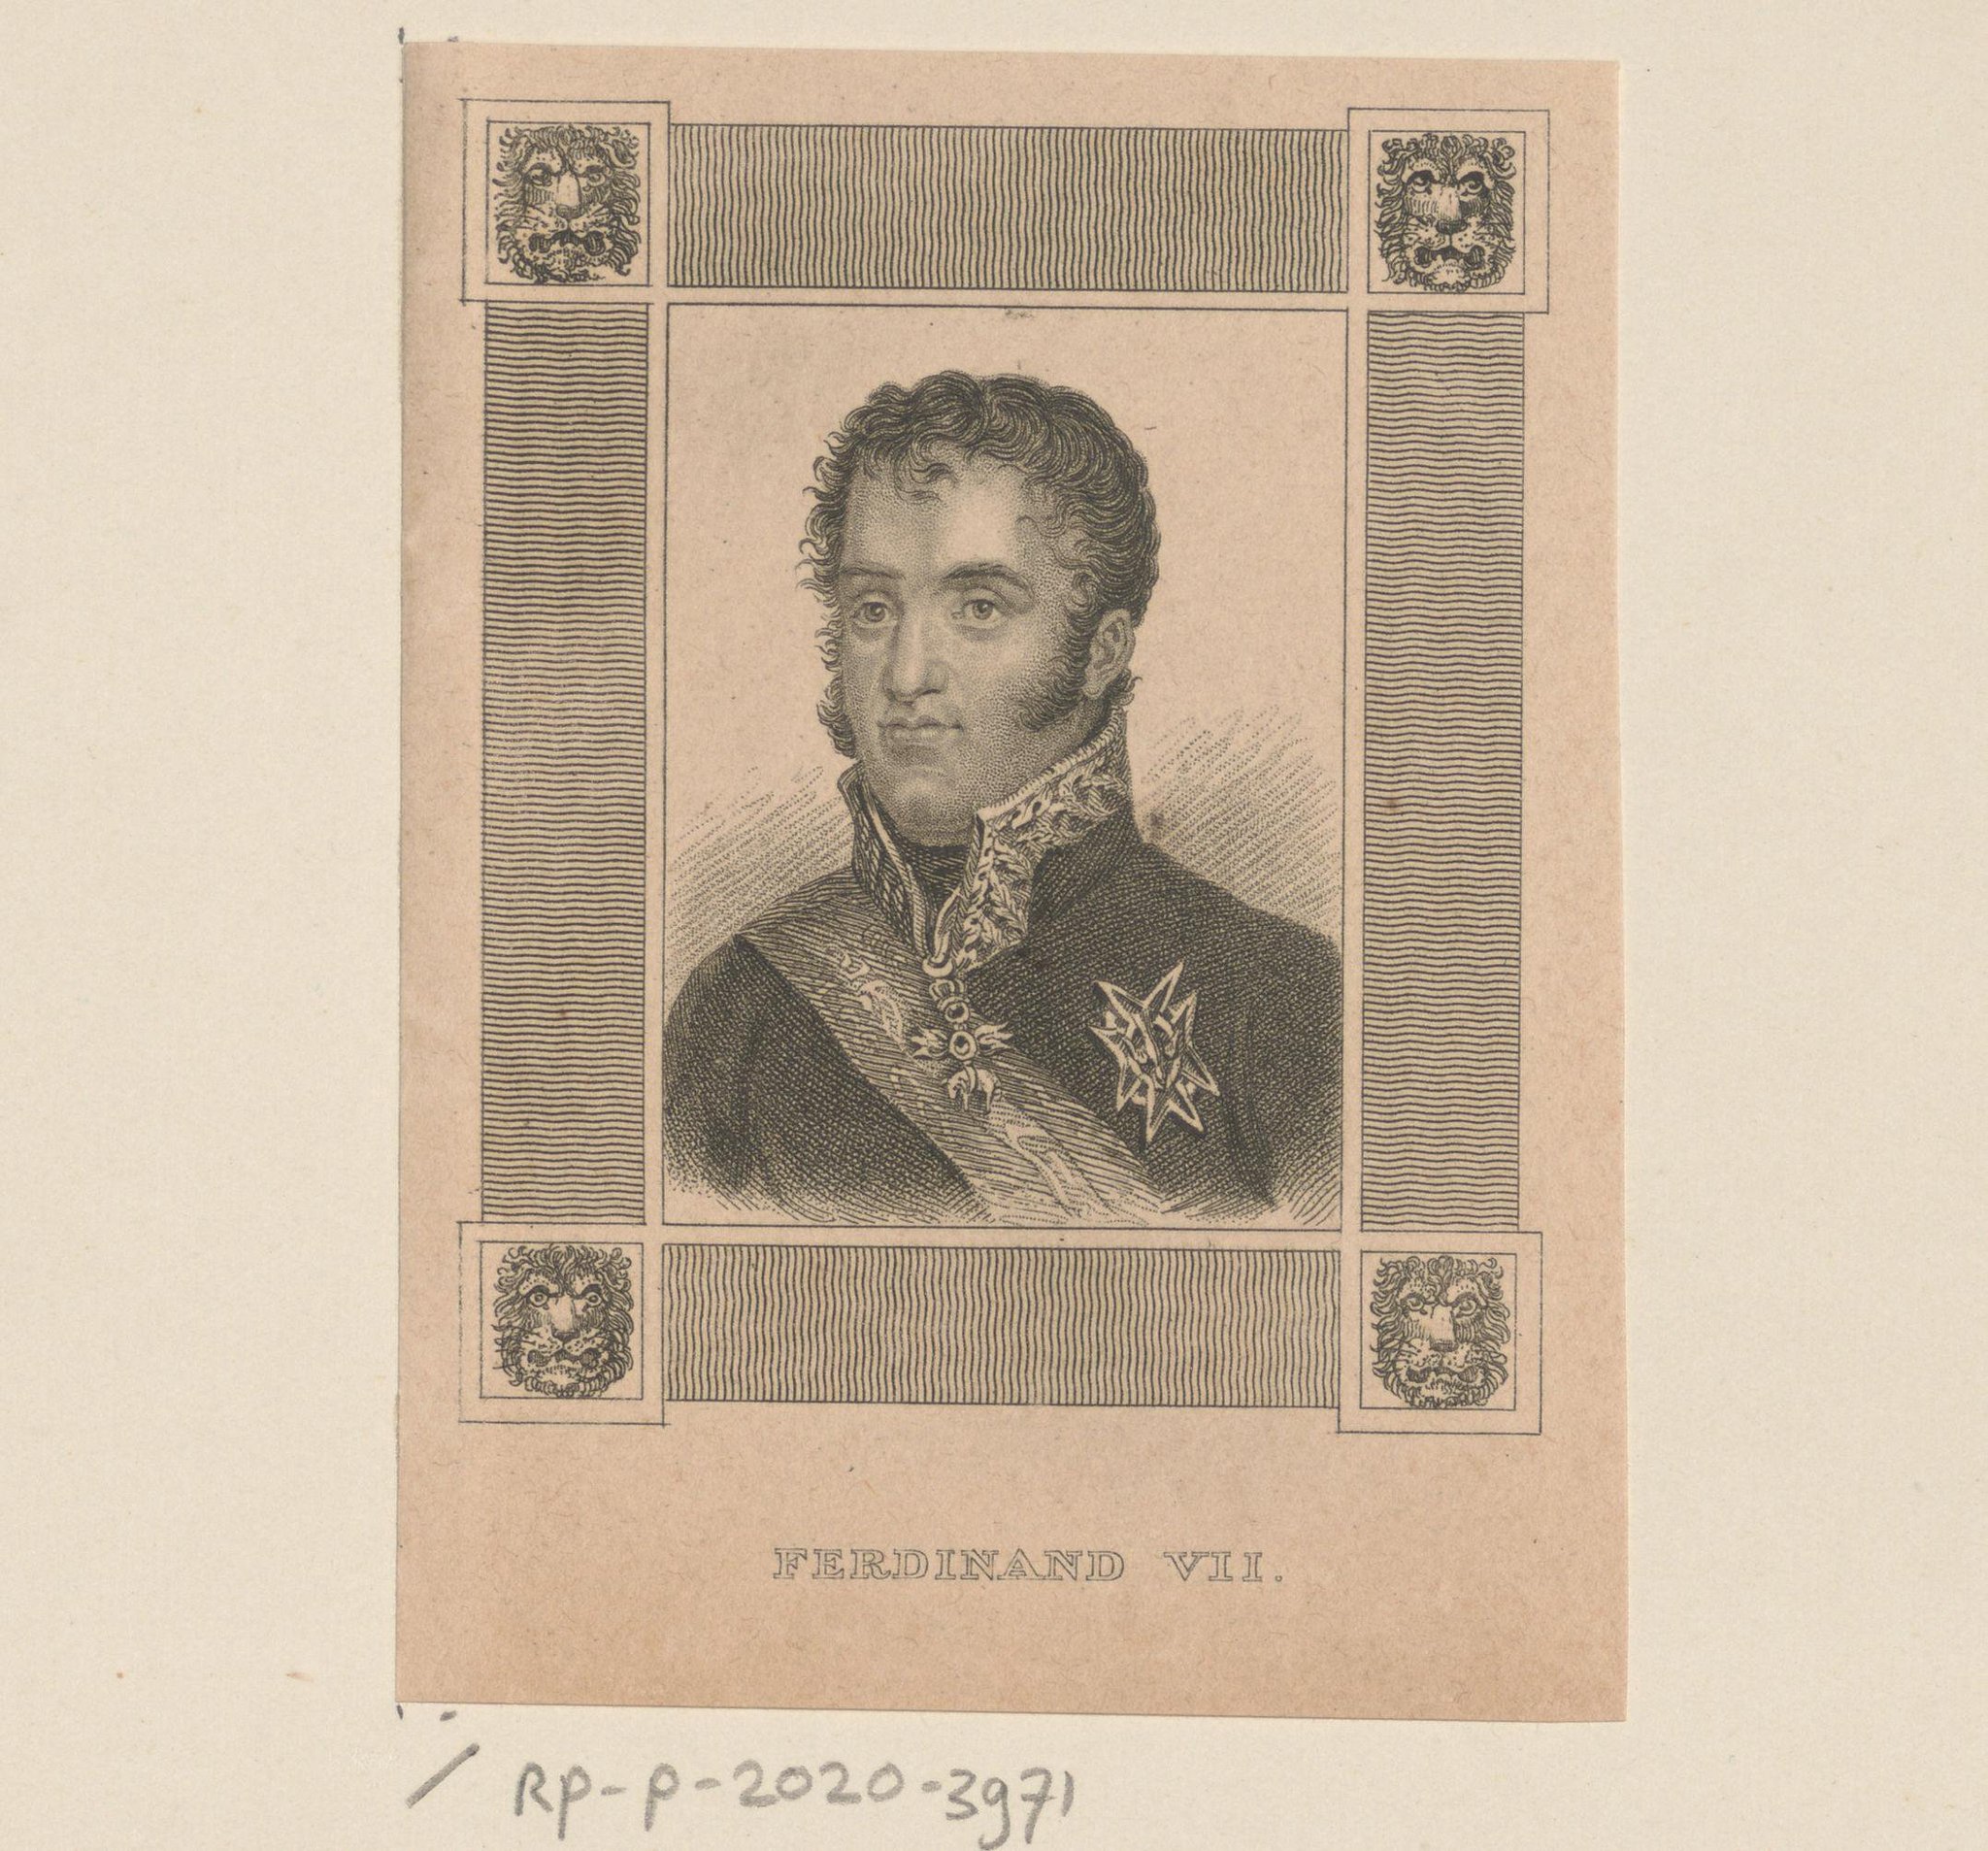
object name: print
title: Portret van Ferdinand VII van Spanje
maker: Anonymous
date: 1814-1850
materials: paper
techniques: etching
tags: ferdinand vii (koning van spanje), historical persons, knighthood order of the golden fleece, king